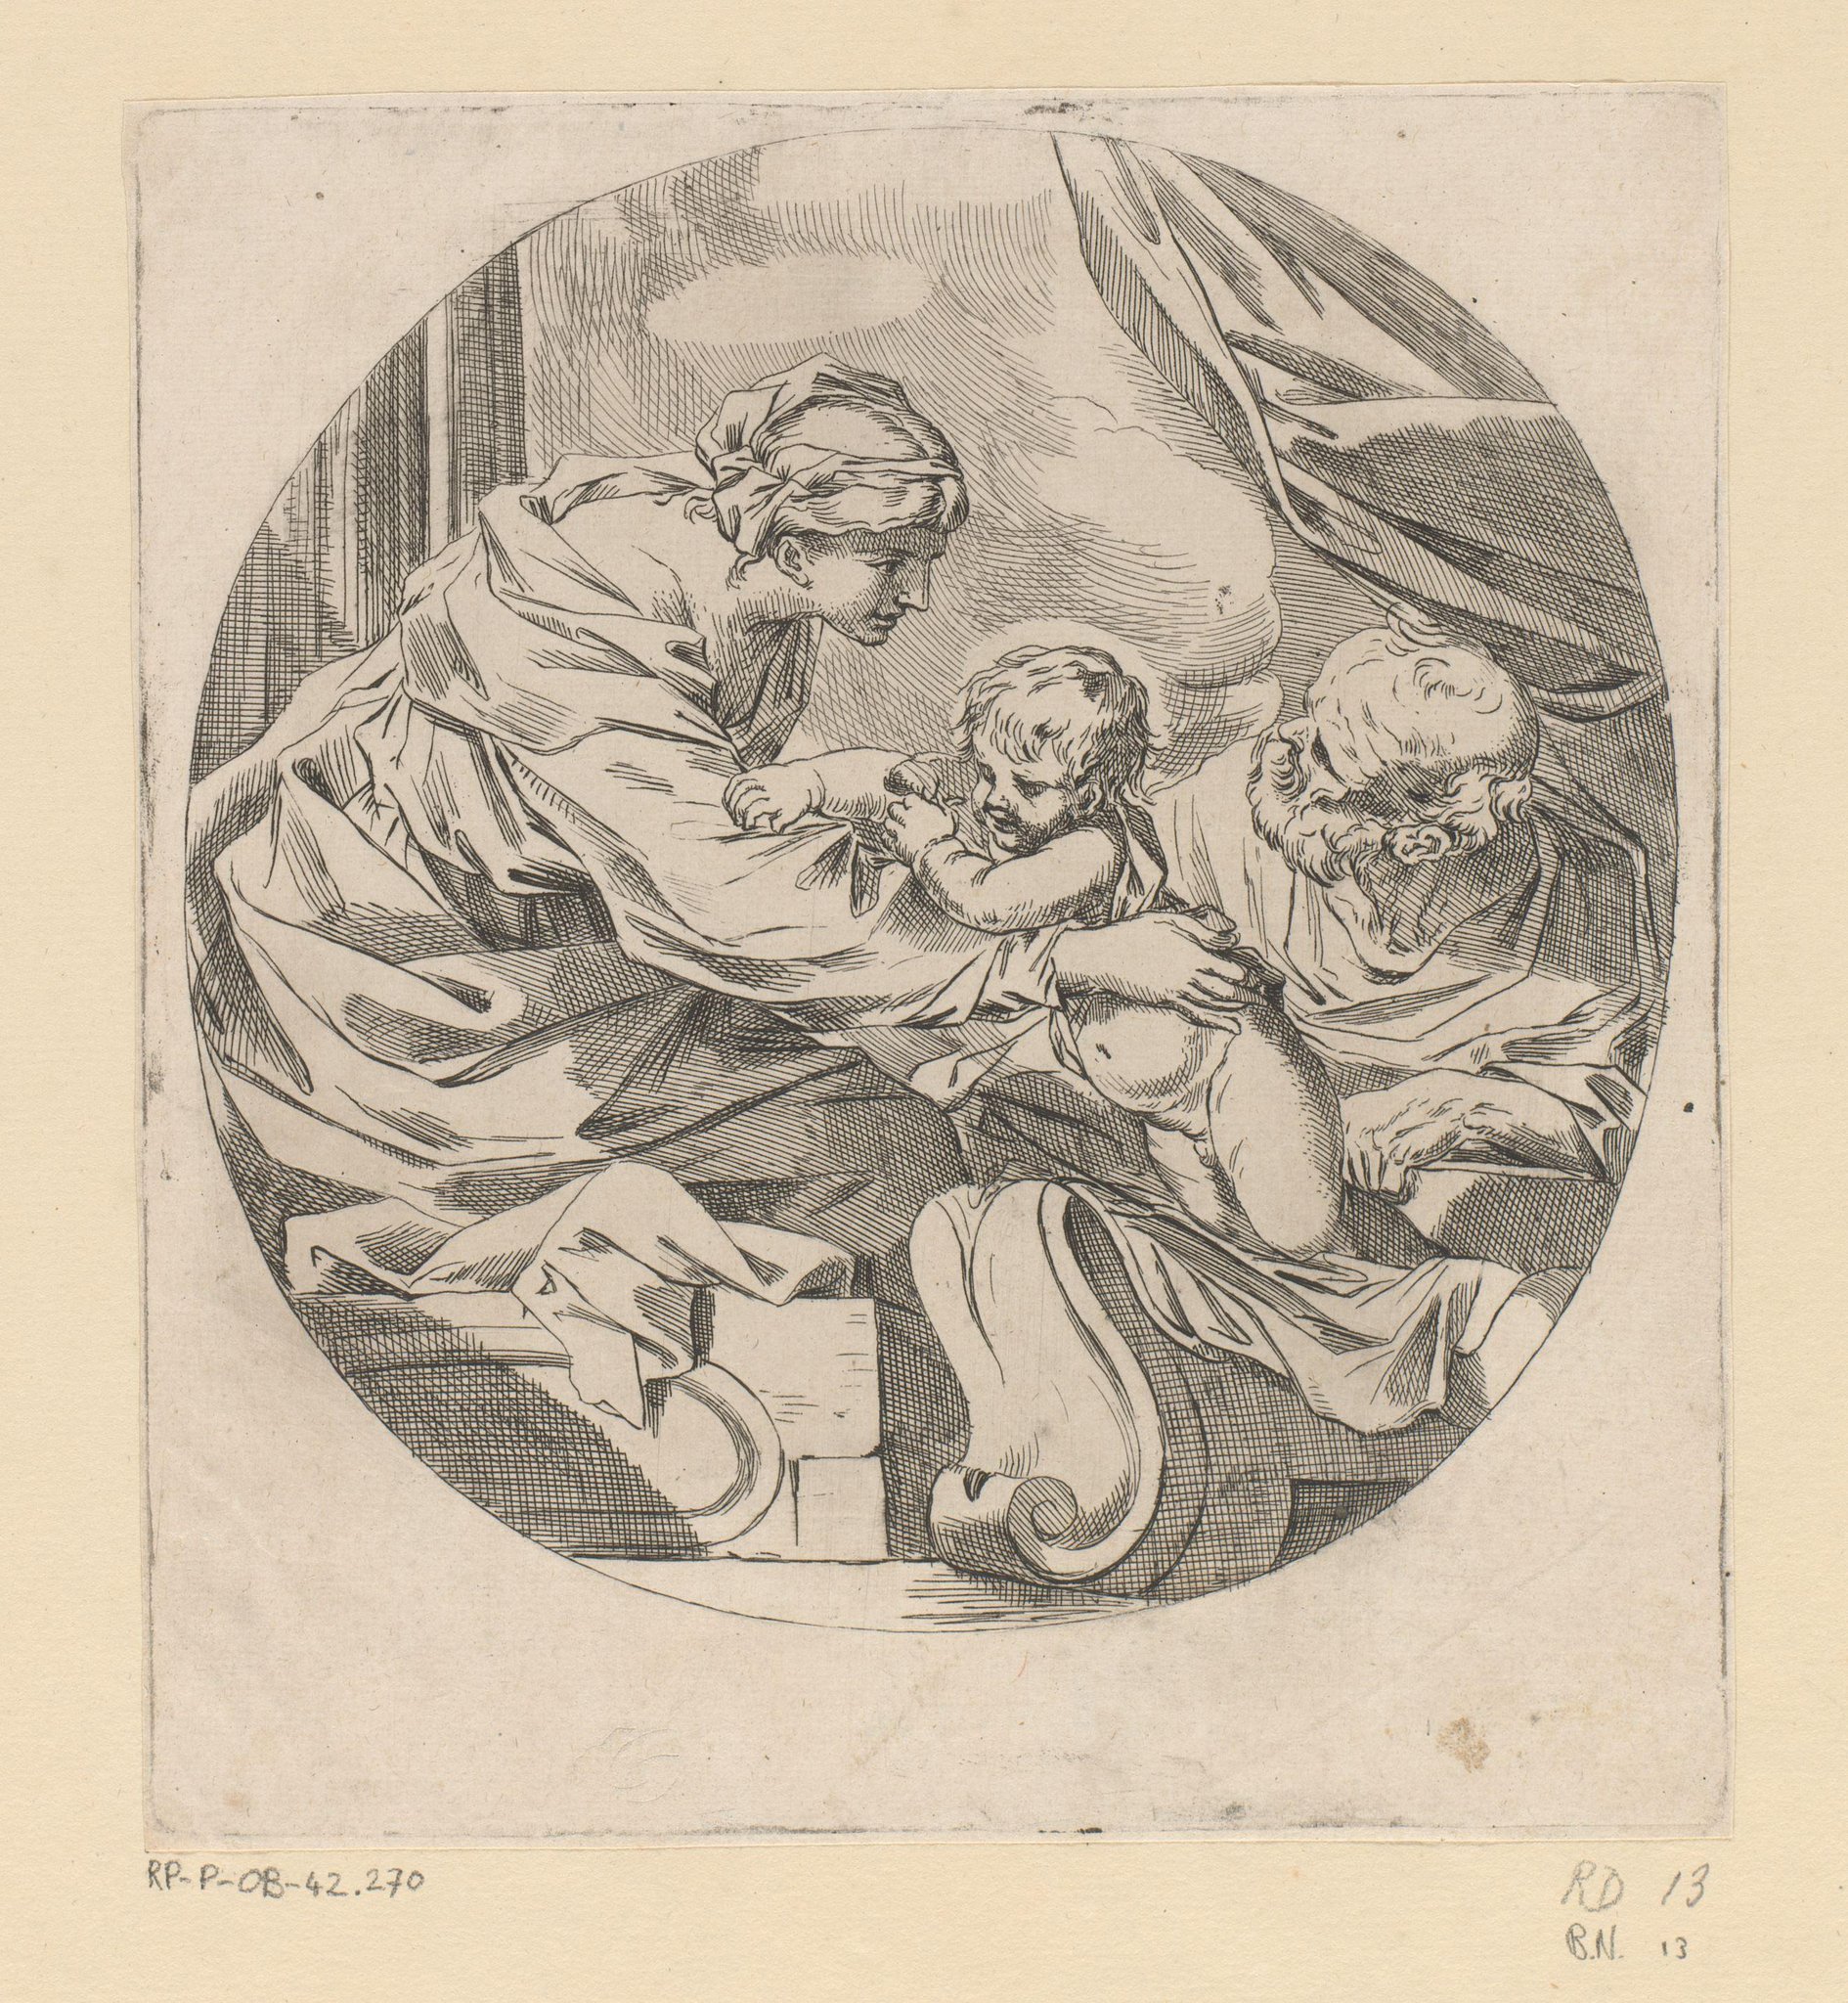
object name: print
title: Heilige Familie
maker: sébastien bourdon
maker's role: draughtsman, painter, print maker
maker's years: 1616-1671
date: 1626-1671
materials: paper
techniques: etching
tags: holy family (alone), 'trinitas terrestris'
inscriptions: collector's mark: Lugt 240, collector's mark: Lugt 240